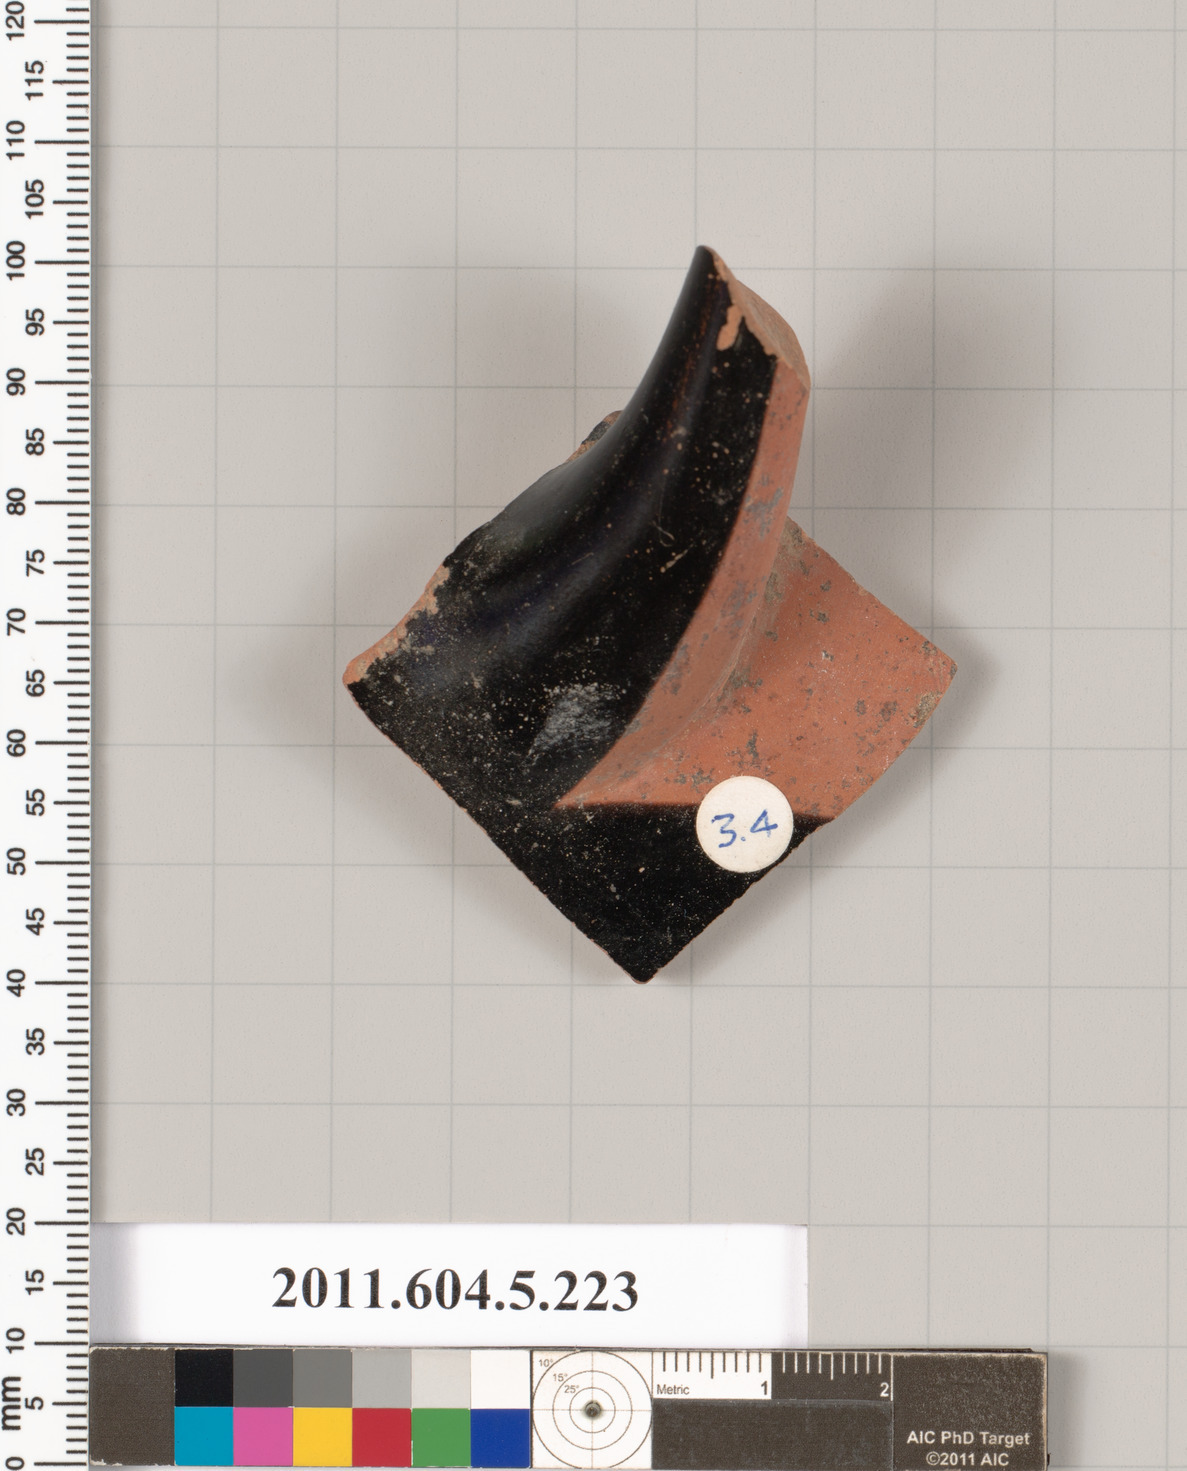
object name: kylix fragment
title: Terracotta fragment of a kylix (drinking cup)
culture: greek, attic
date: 600-401 BCE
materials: terracotta